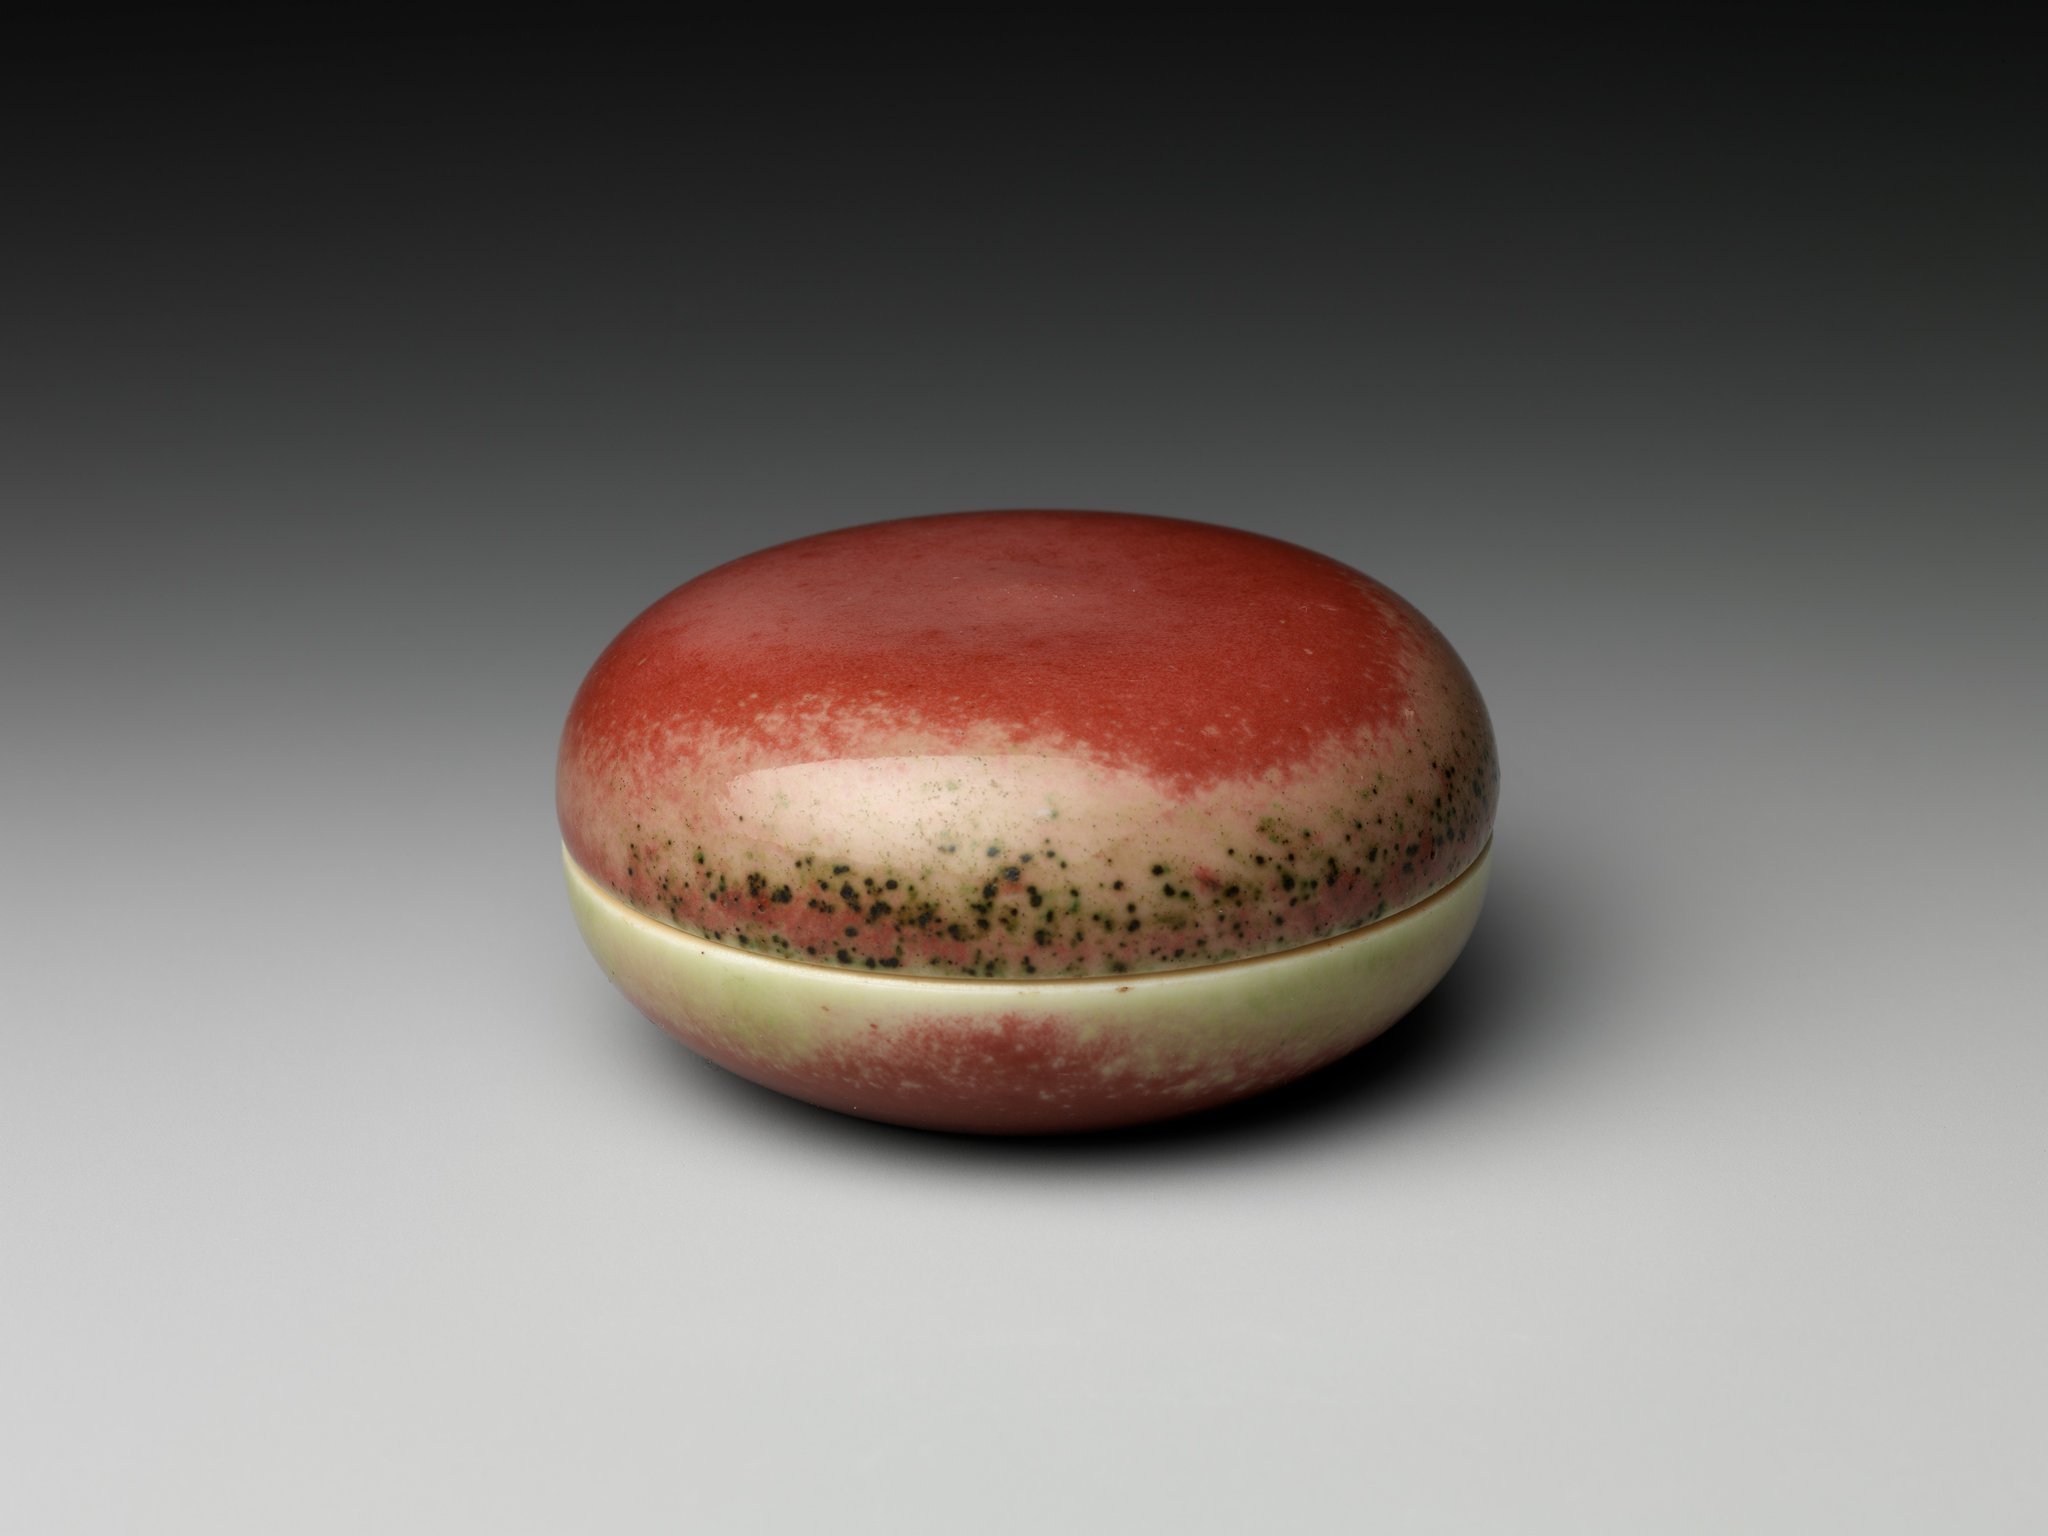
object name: box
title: Box for seal paste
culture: chinese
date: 1713-1722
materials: glaze, porcelain